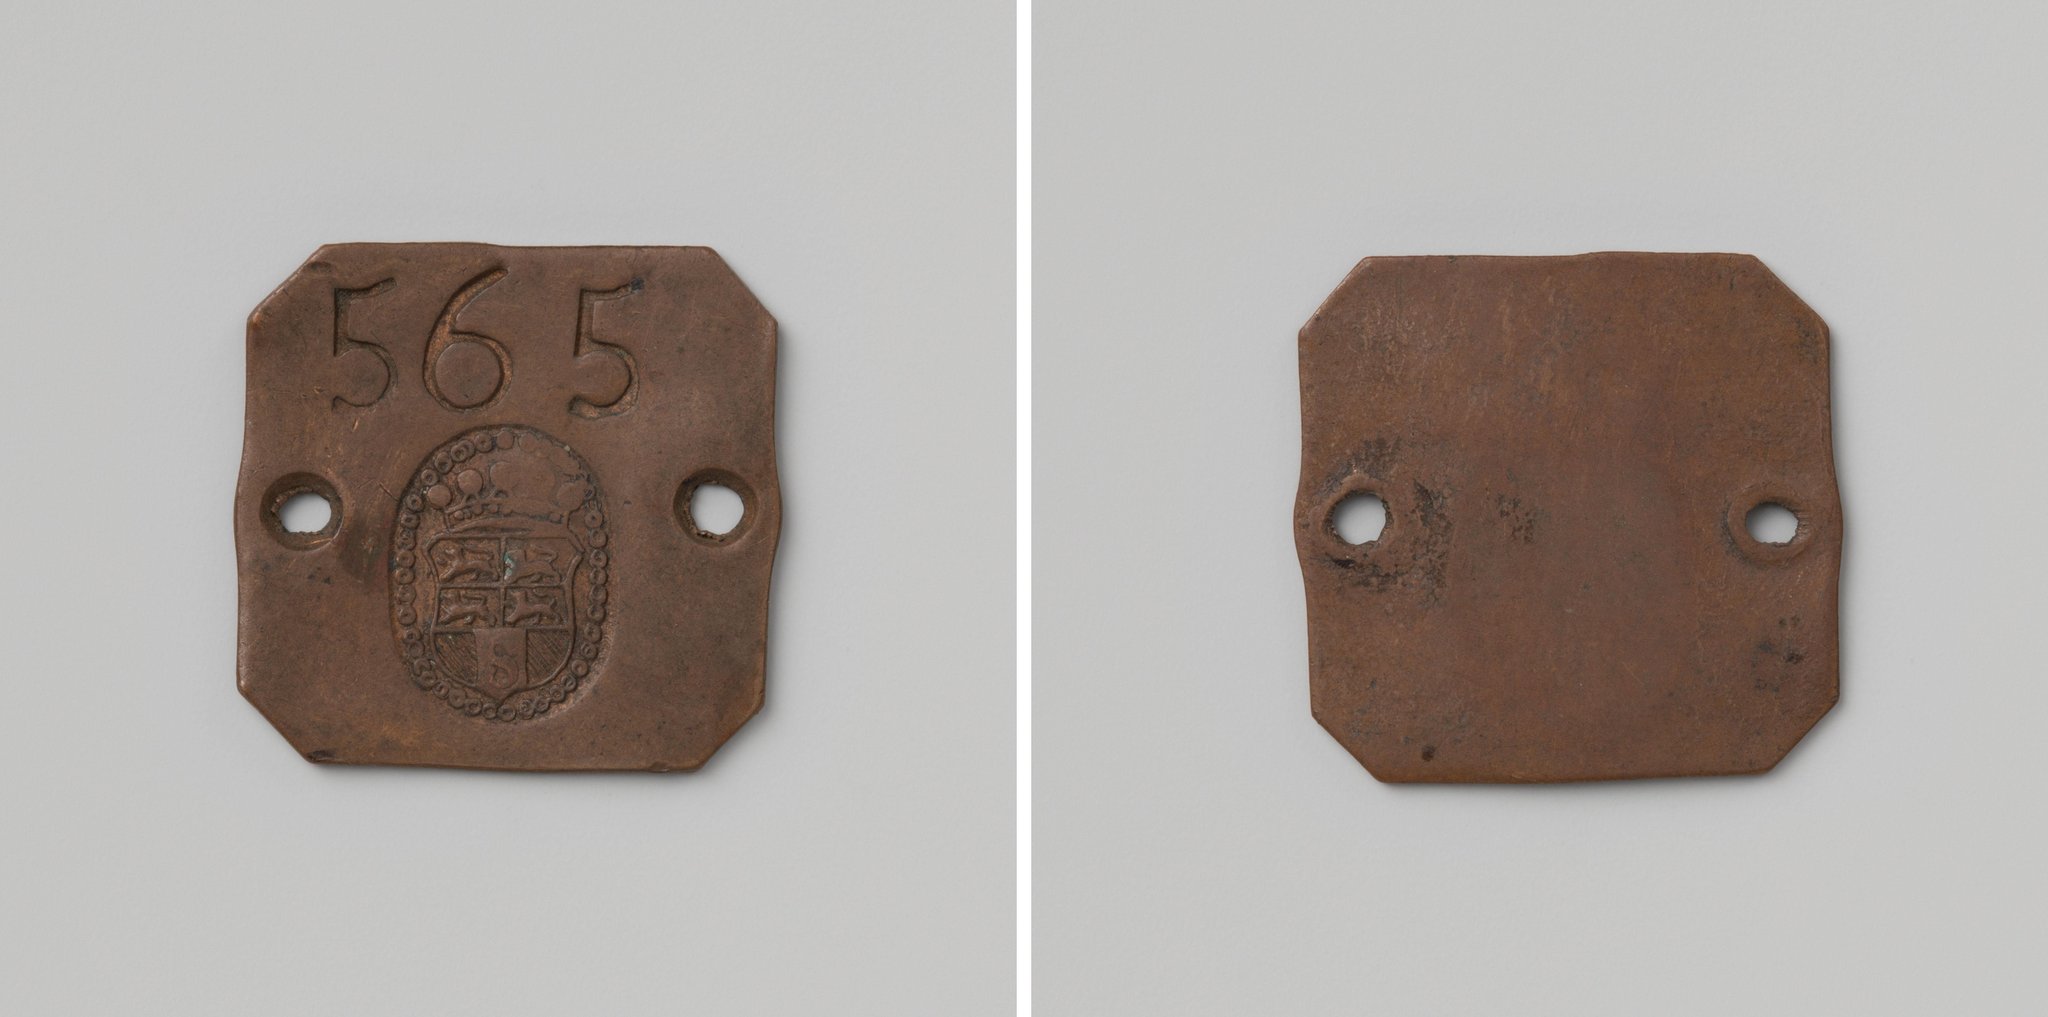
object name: tax token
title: Stad Rotterdam, loodje met no. 565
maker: Anonymous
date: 1800-1875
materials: copper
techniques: striking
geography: rotterdam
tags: rotterdam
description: eenzijdig, vierkant loodje met afgeschuinde hoeken en links en rechts een gat. Voorzijde: wapenschild binnen parelrand onder cijfer 565; op onderste deel van wapenschild: letter S. Keerzijde: blanco